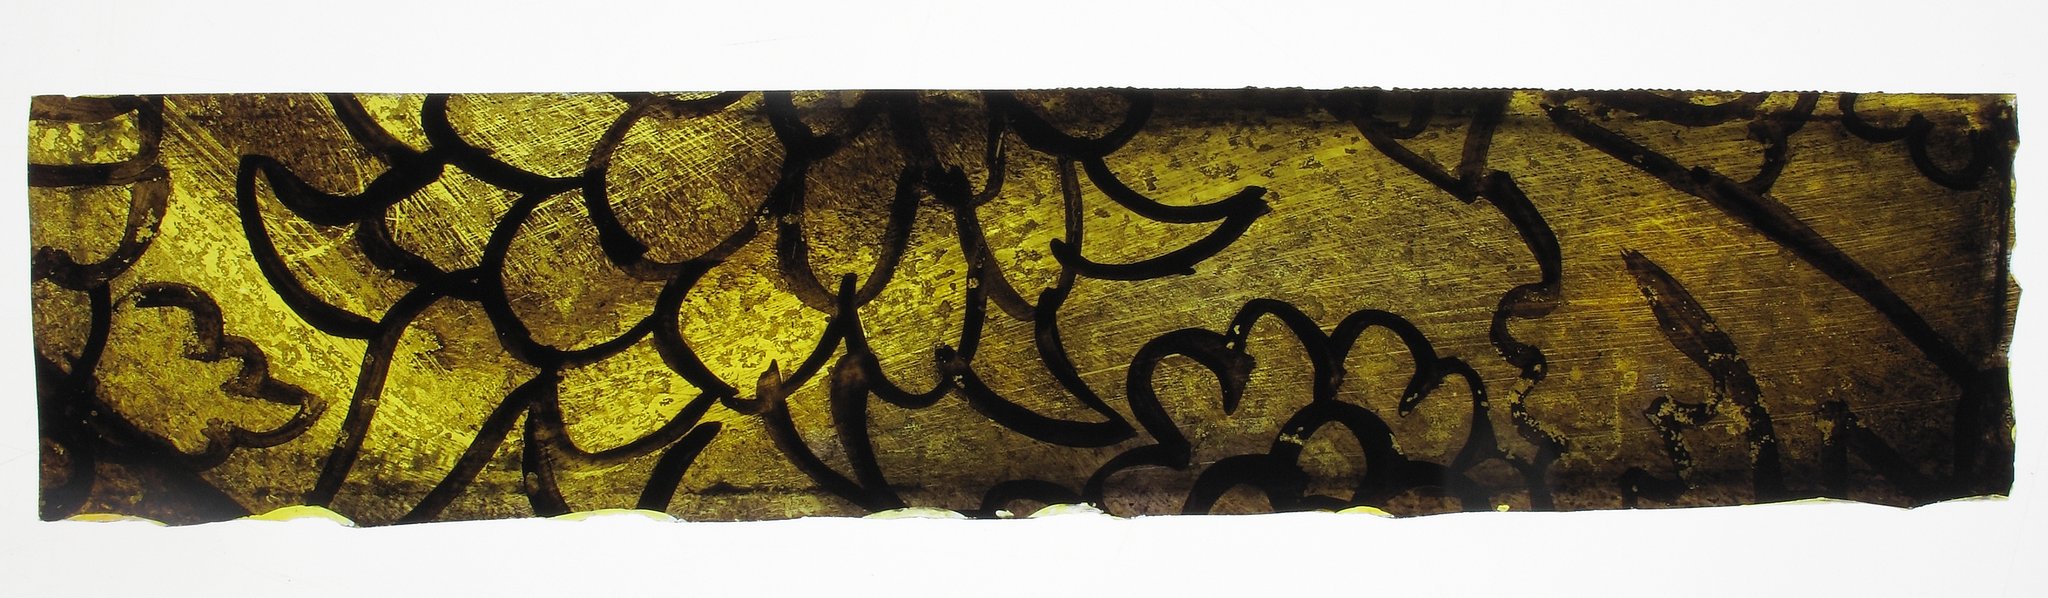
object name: fragment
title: Glass Fragment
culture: european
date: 1401-1500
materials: glass, pigment